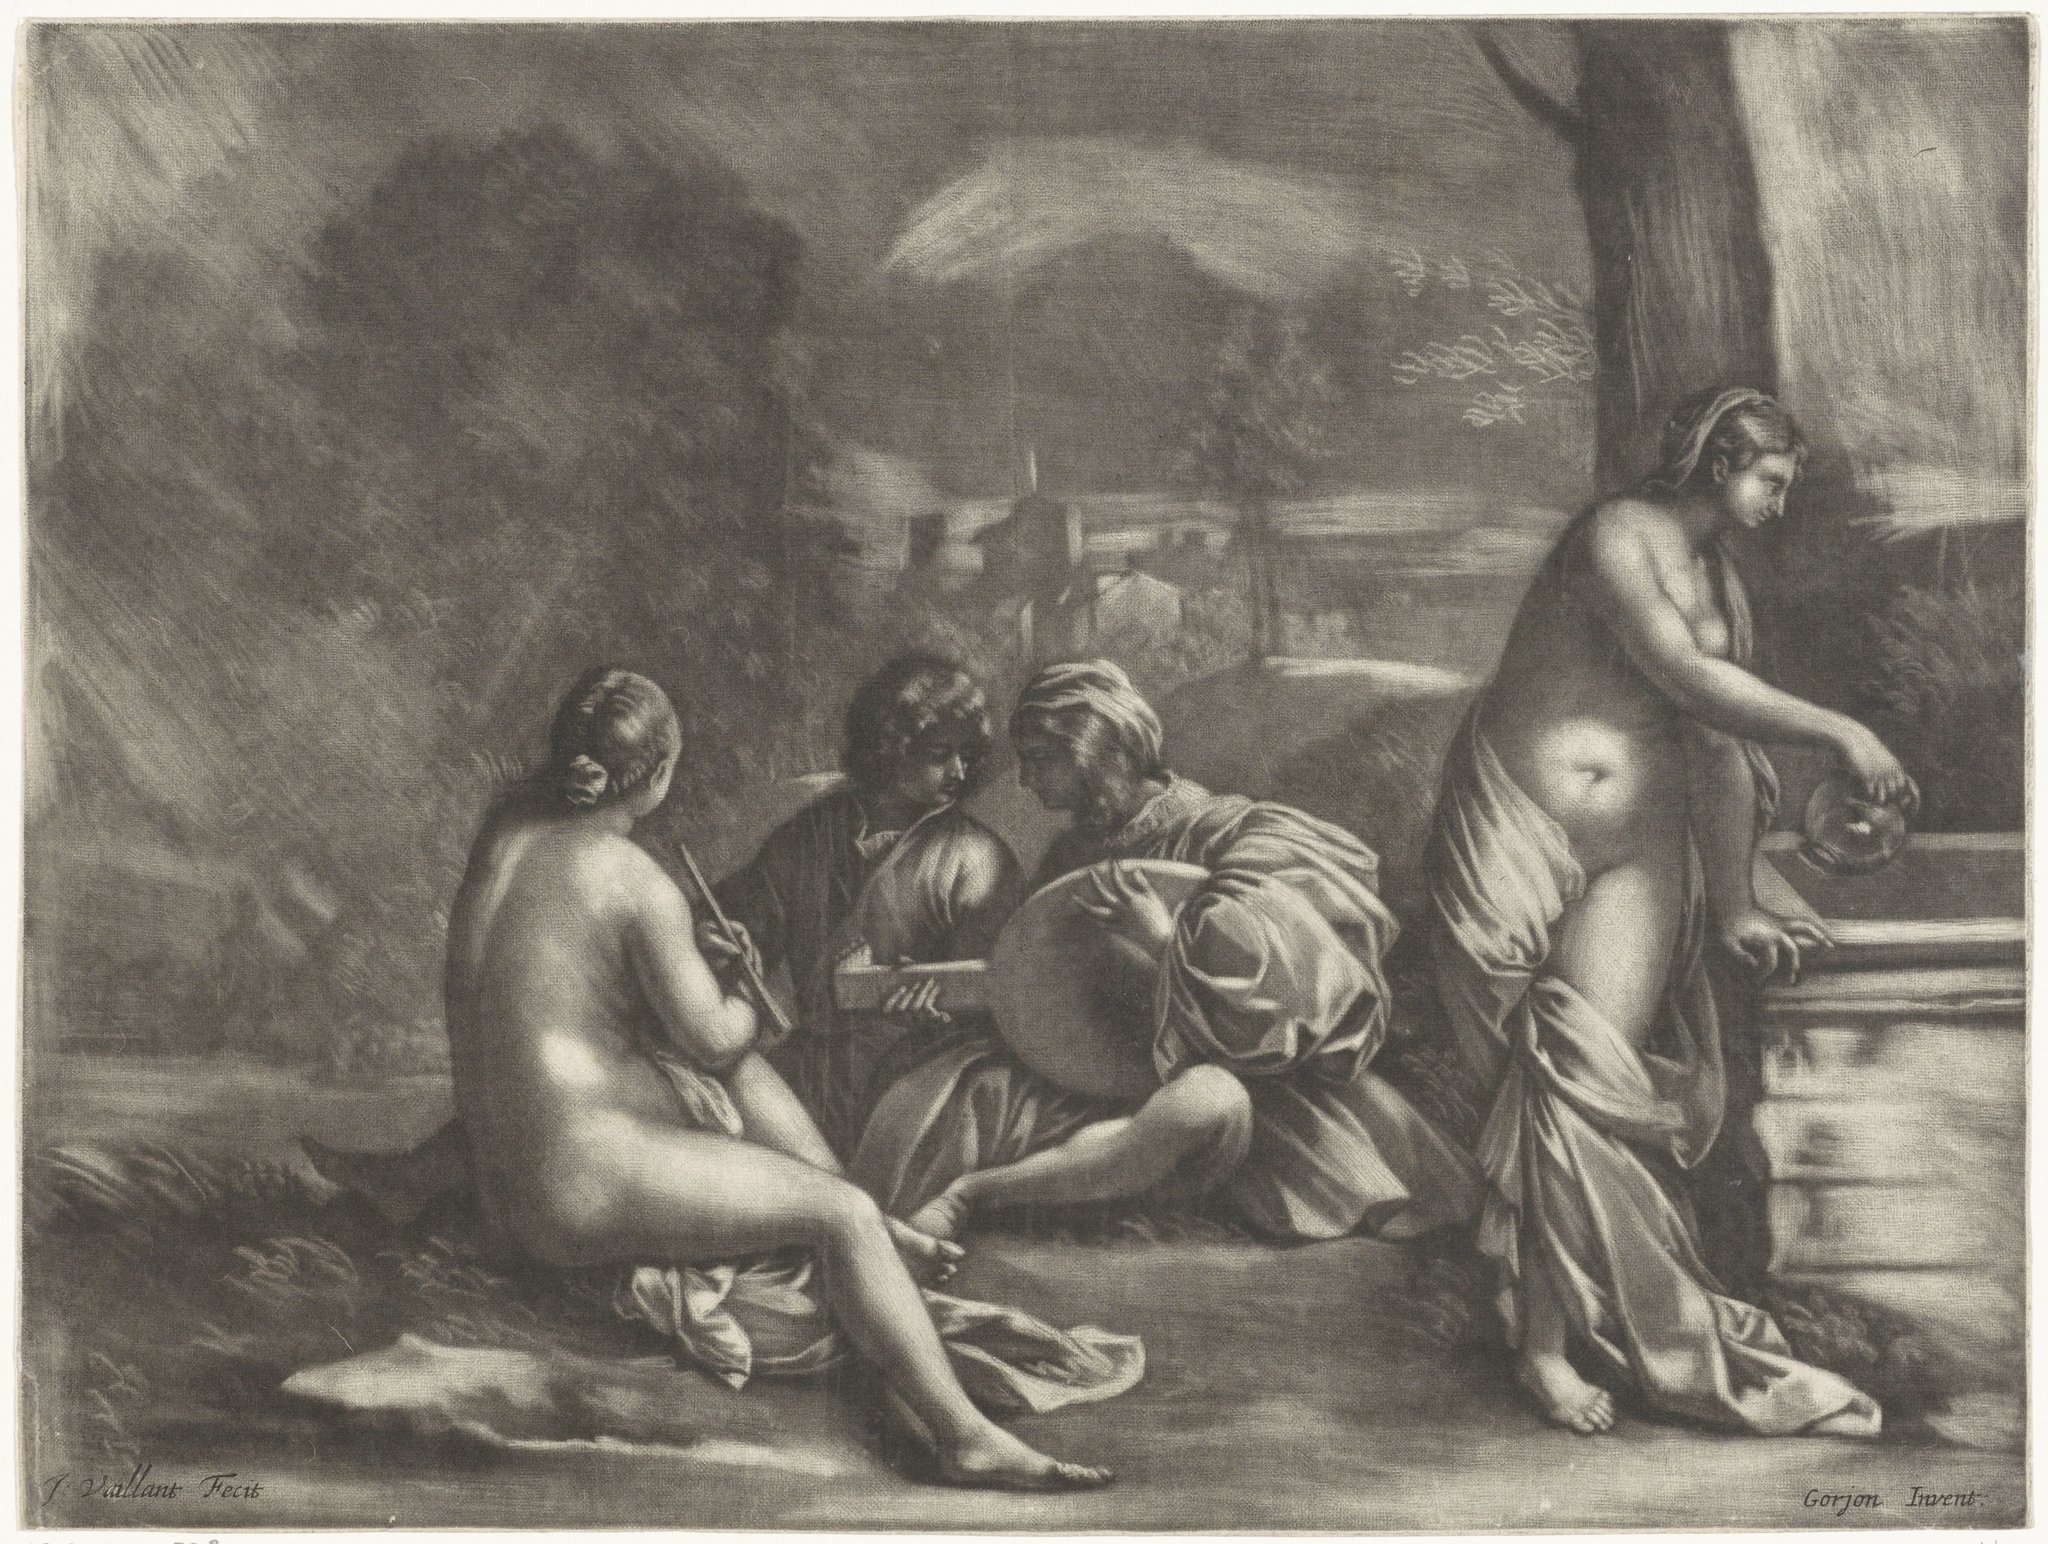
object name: print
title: Gezelschap bij een bron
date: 1653-1691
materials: paper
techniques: mezzotint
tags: private festivities, merry company - aa - in the open air, 'fête champêtre'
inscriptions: collector's mark: Lugt 2228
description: Twee musicerende jonge mannen en twee naakte vrouwen houden zich op bij een bron. Op de achtergrond de contouren van een dorp.